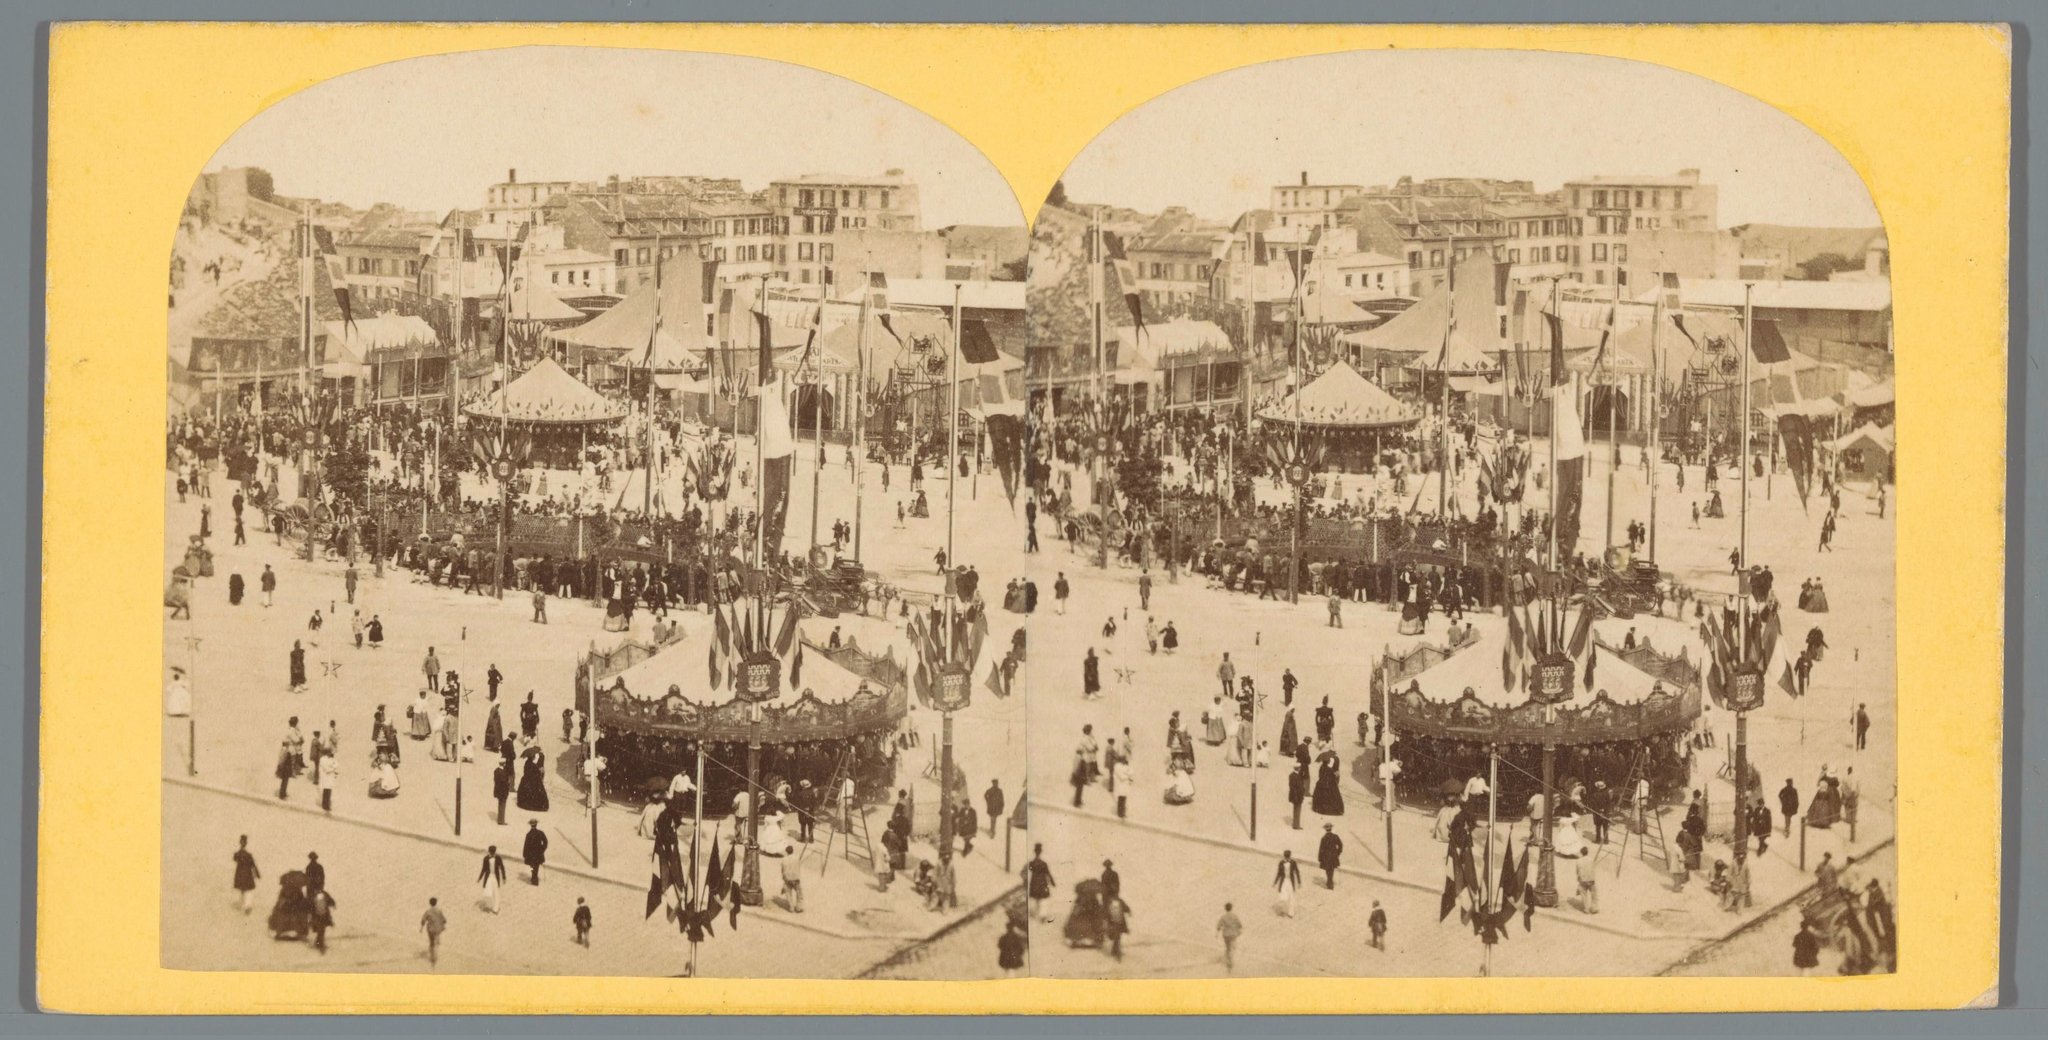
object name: stereograph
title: Place St. Pierre Le jour de la Fête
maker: Anonymous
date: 1850-1880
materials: cardboard, photographic support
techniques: albumen print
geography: paris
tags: public festivities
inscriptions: number: ‘No. 119’